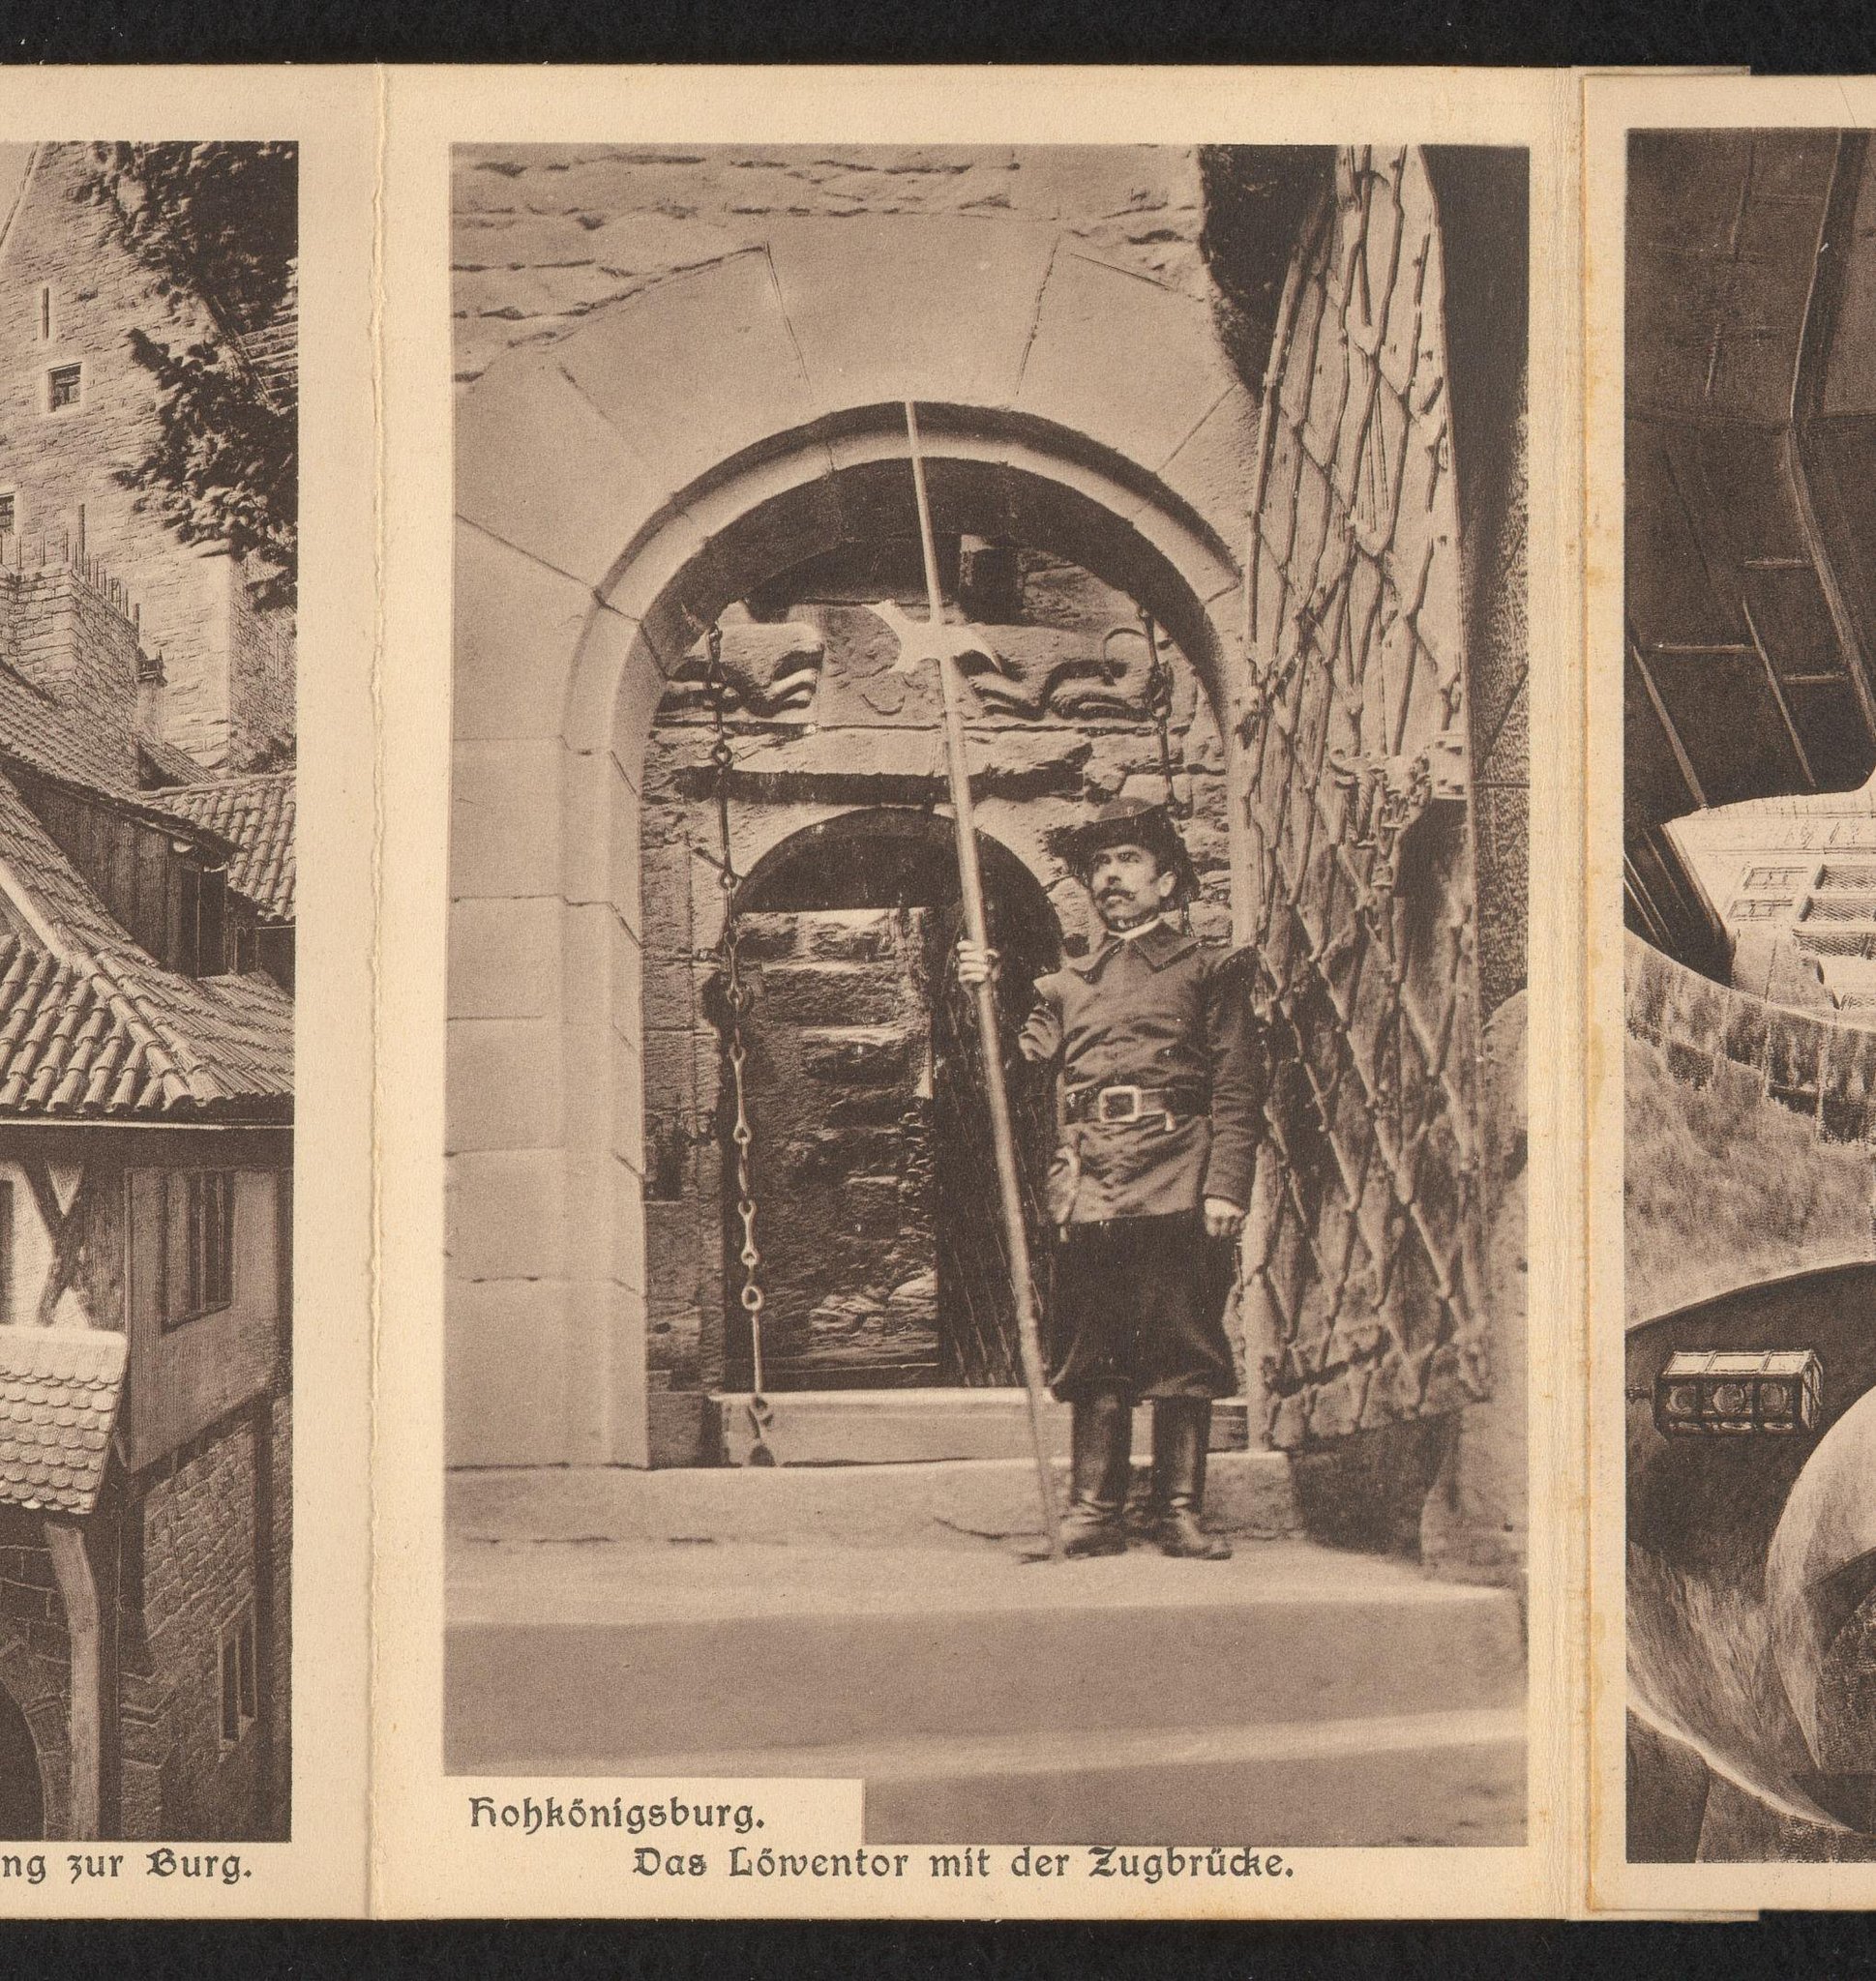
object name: ansichtkaart, prentbriefkaart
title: Hohkönigsburg. Das Löwentor mit der Zugbrücke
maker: Anonymous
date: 1908-1913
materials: cardboard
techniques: photograph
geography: alsace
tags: castle, gate, entrance, guard of honour, bridge